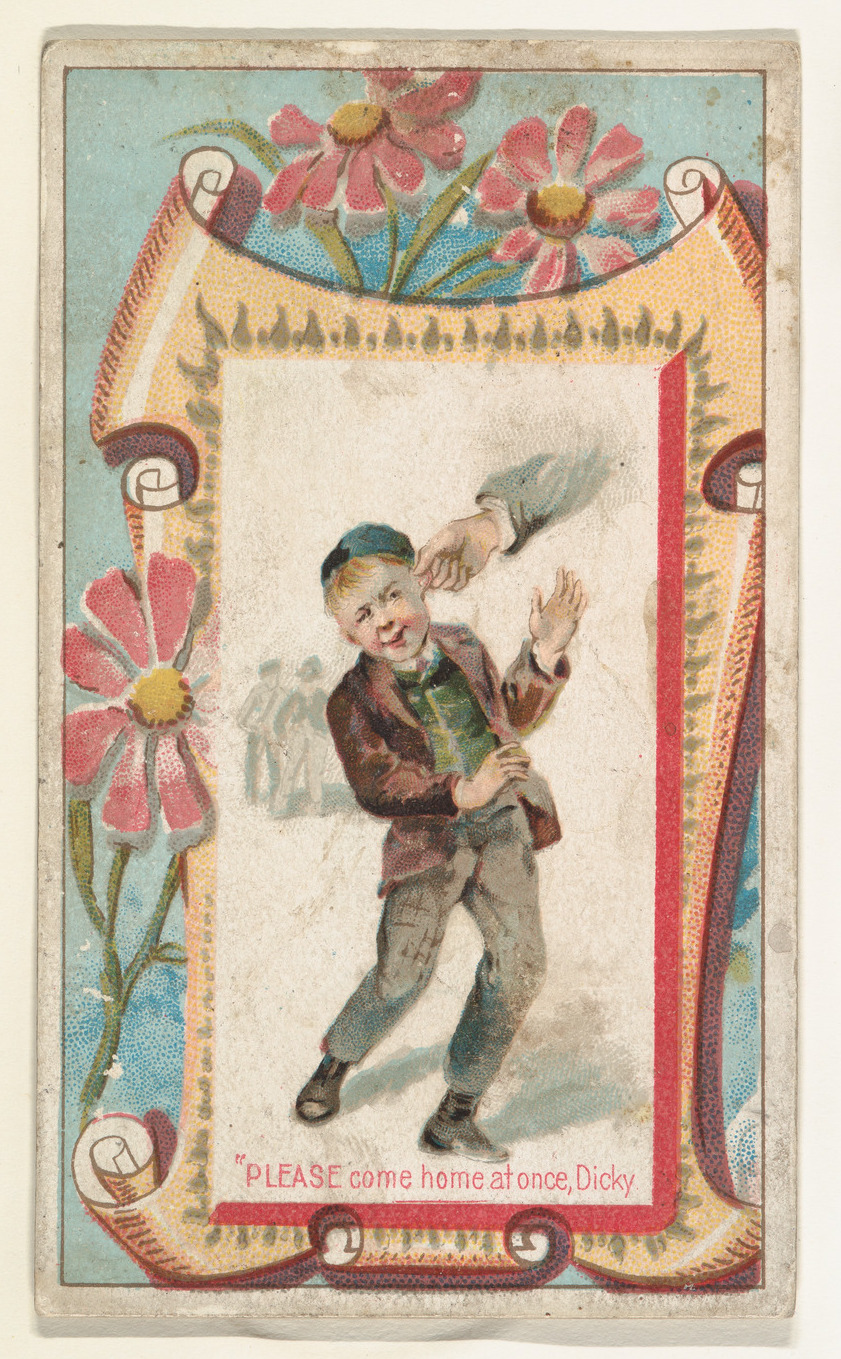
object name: print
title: "Please come home at once, Dicky," from the Terrors of America set (N136) issued by Duke Sons & Co. to promote Honest Long Cut Tobacco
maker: w. duke, sons & co.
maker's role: publisher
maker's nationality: american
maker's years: 1870-1920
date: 1888-1889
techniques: color lithograph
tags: boys